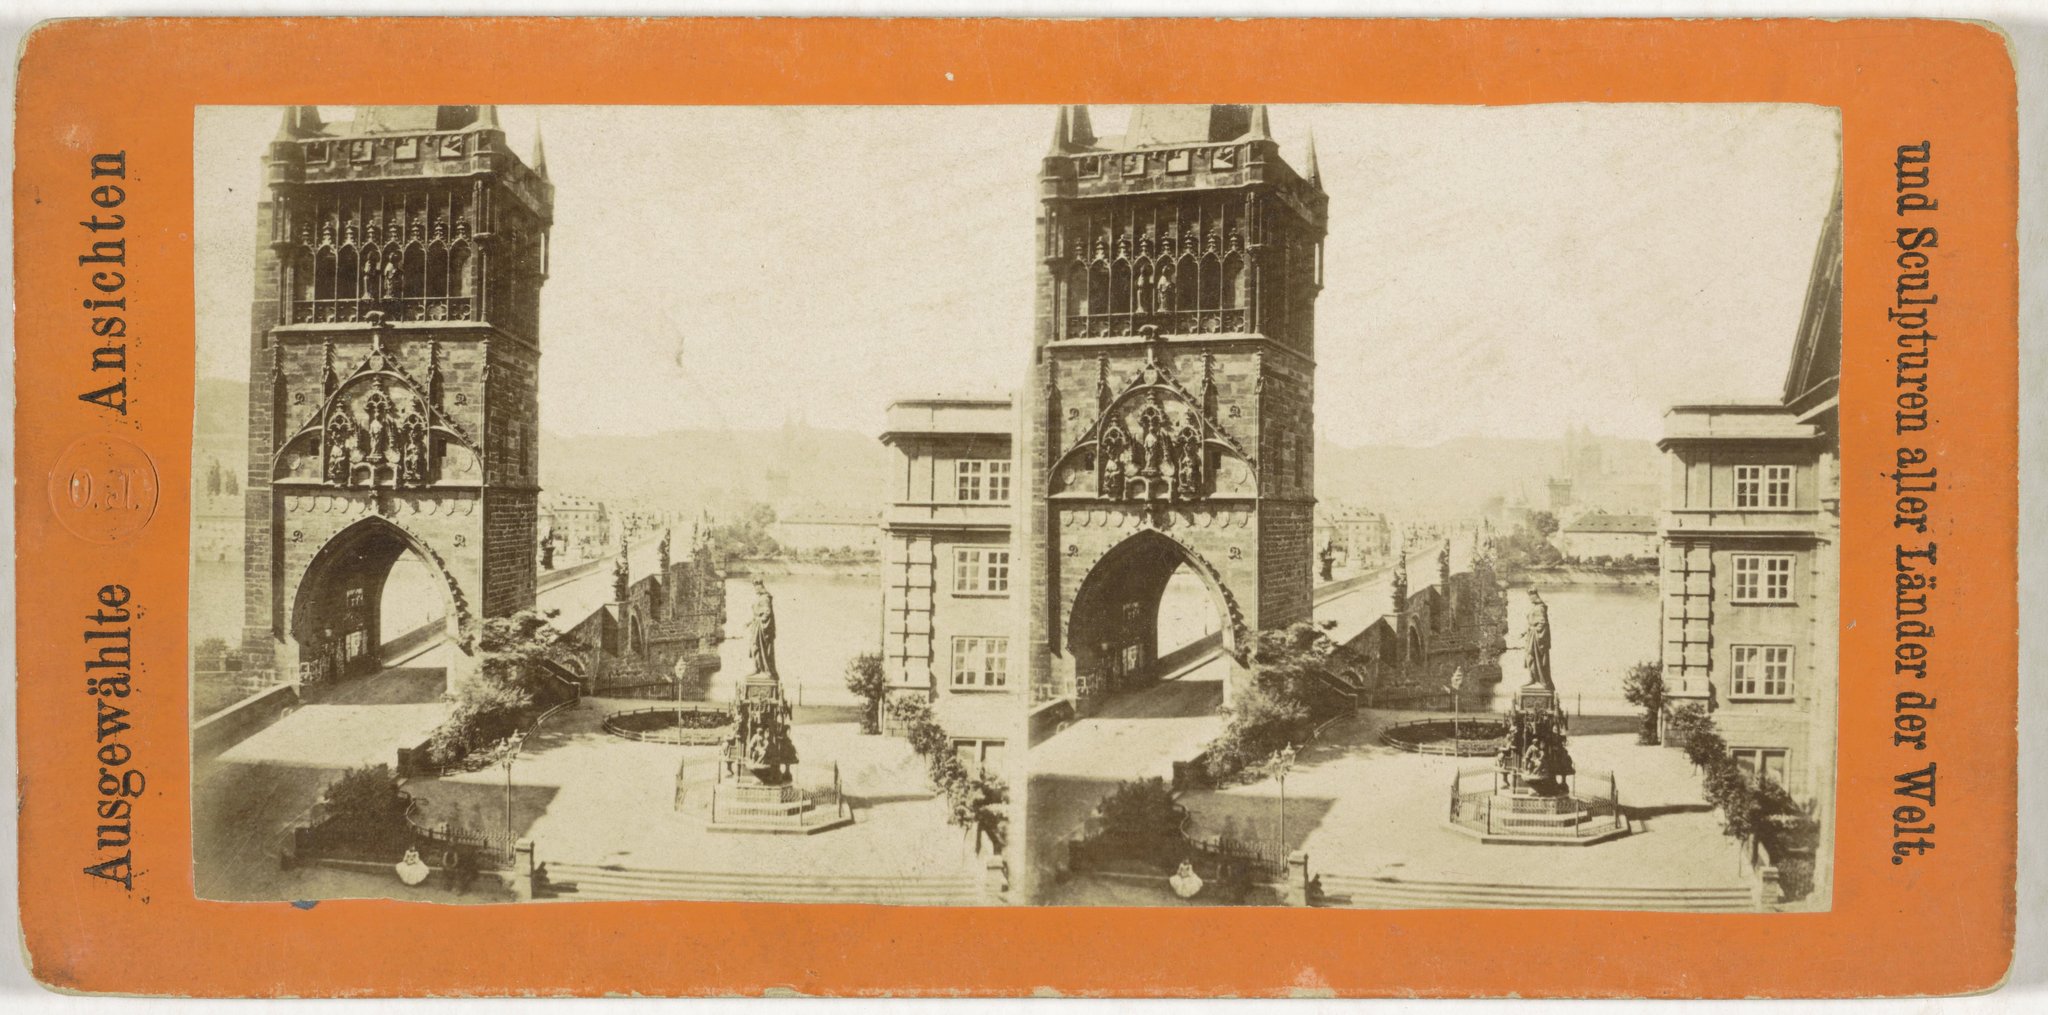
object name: stereograph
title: Karelsbrug en het monument voor keizer Karel IV, Praag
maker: o.j.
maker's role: fotograaf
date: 1868-1890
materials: cardboard, paper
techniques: albumen print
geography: prague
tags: towers ~ fortified city, monument, statue, bridge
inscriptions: number: ‘179’, number: ‘88’